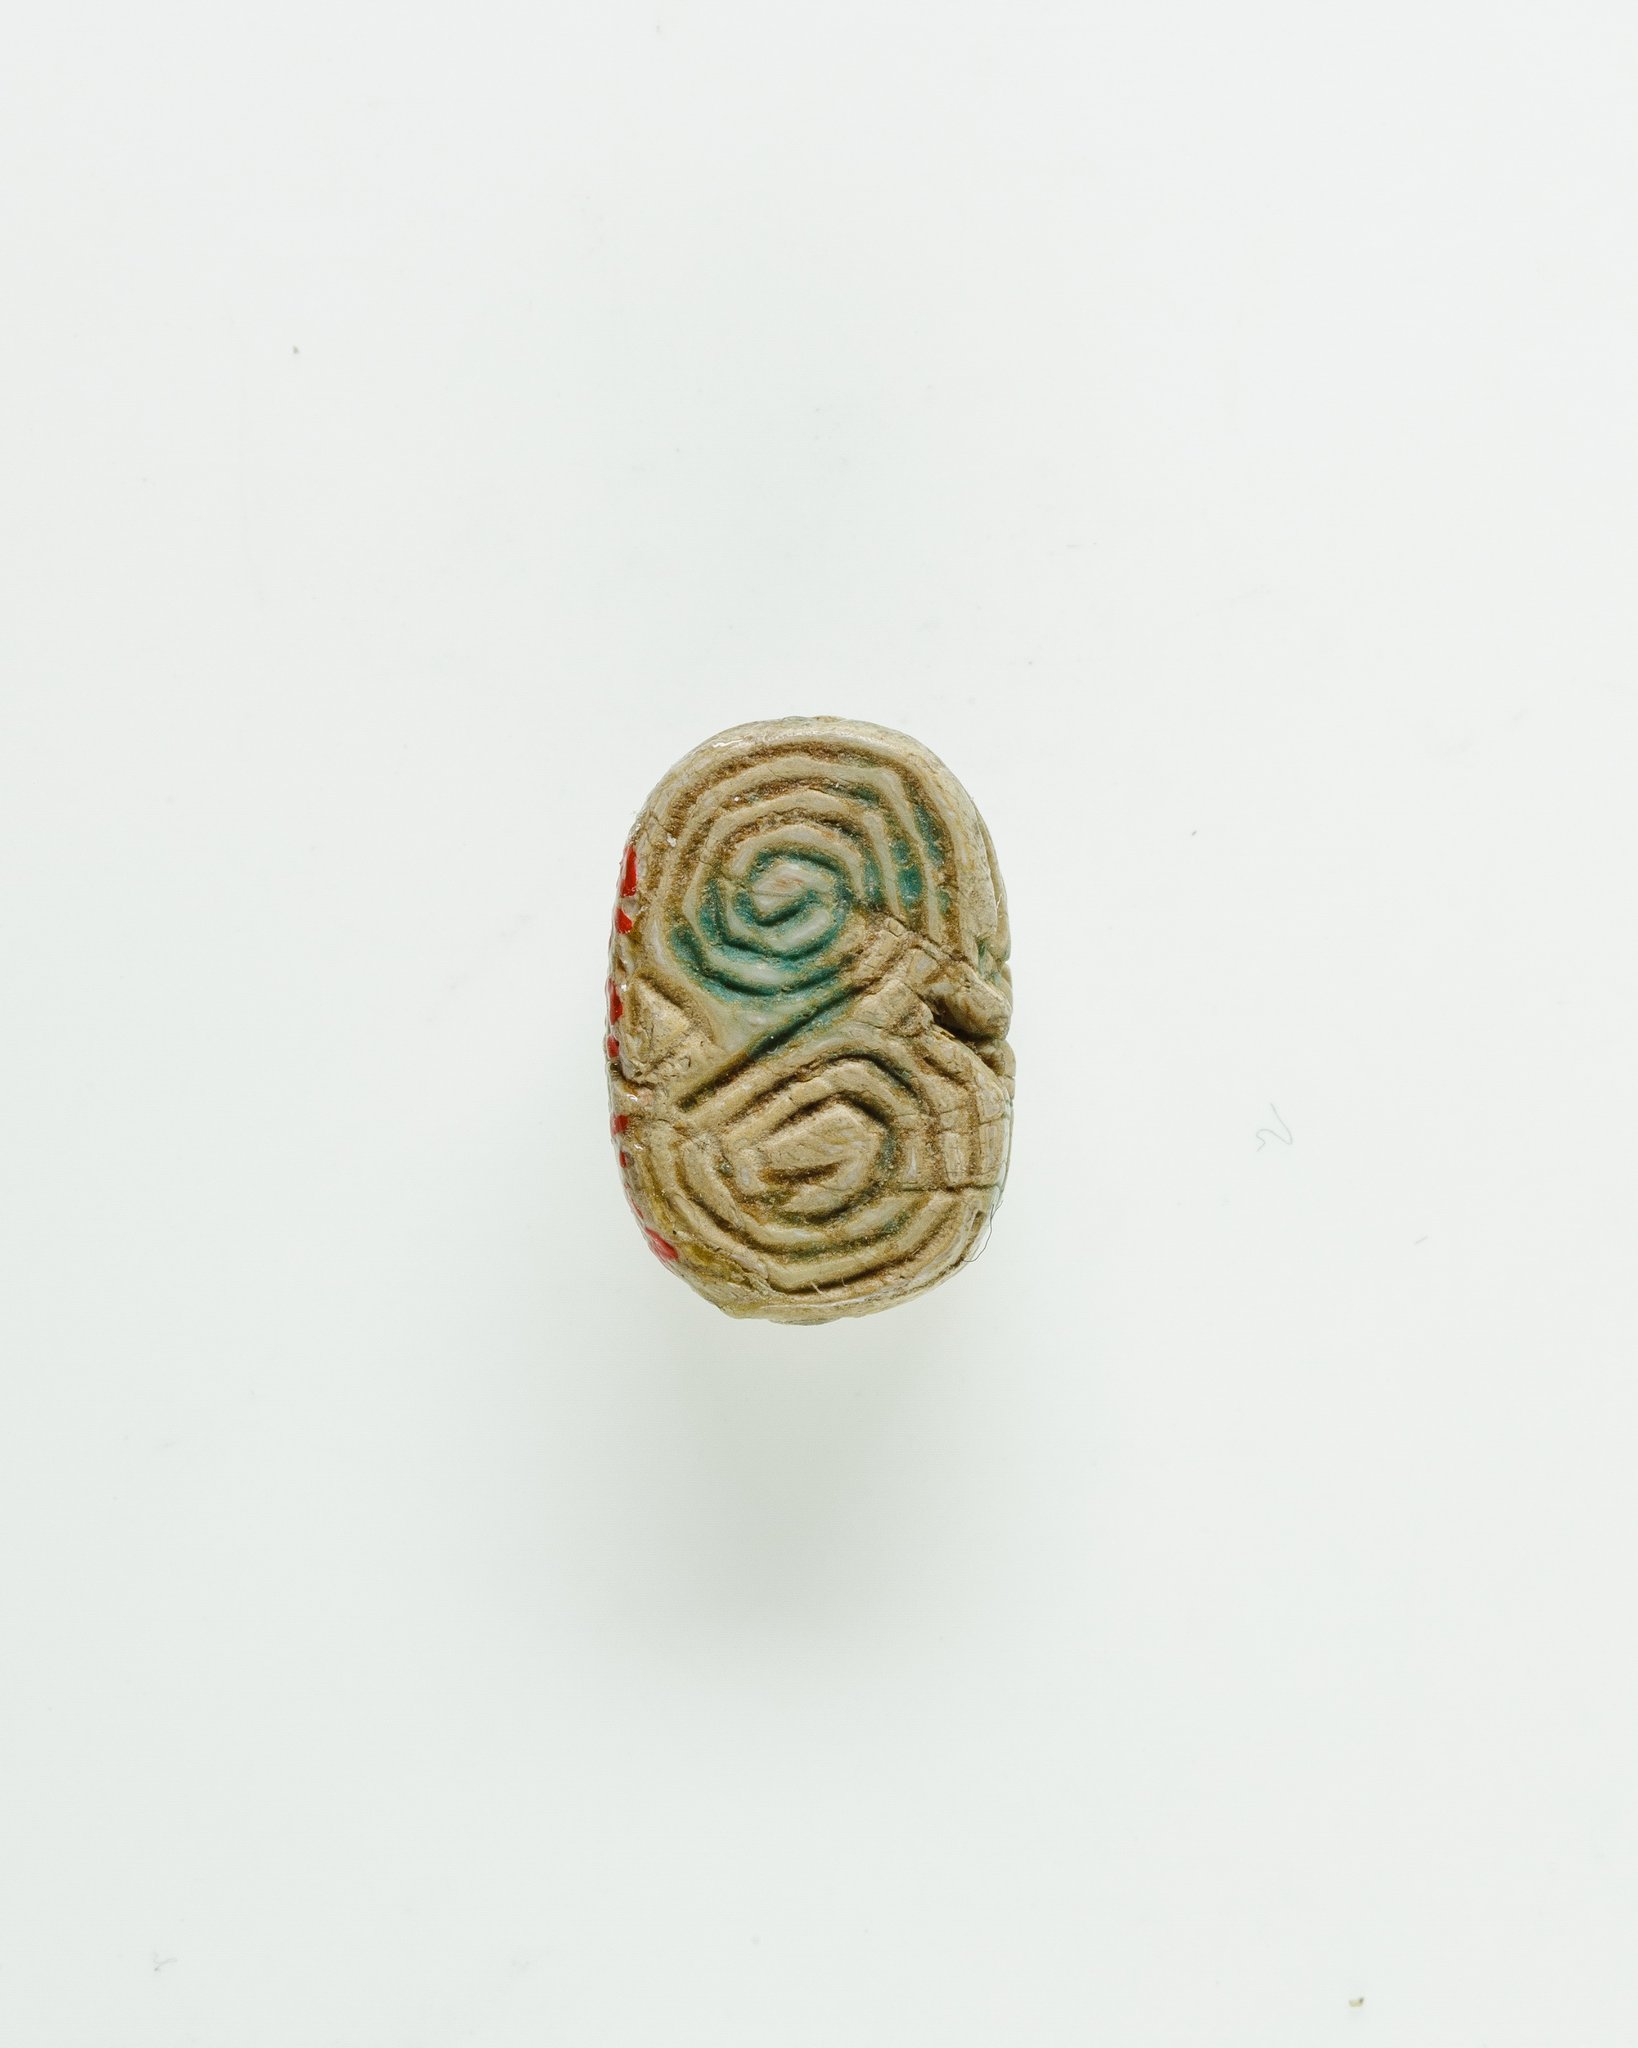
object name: scarab, scroll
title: Scarab Decorated with Scroll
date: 1981-1850 BCE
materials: glaze, stone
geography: egypt